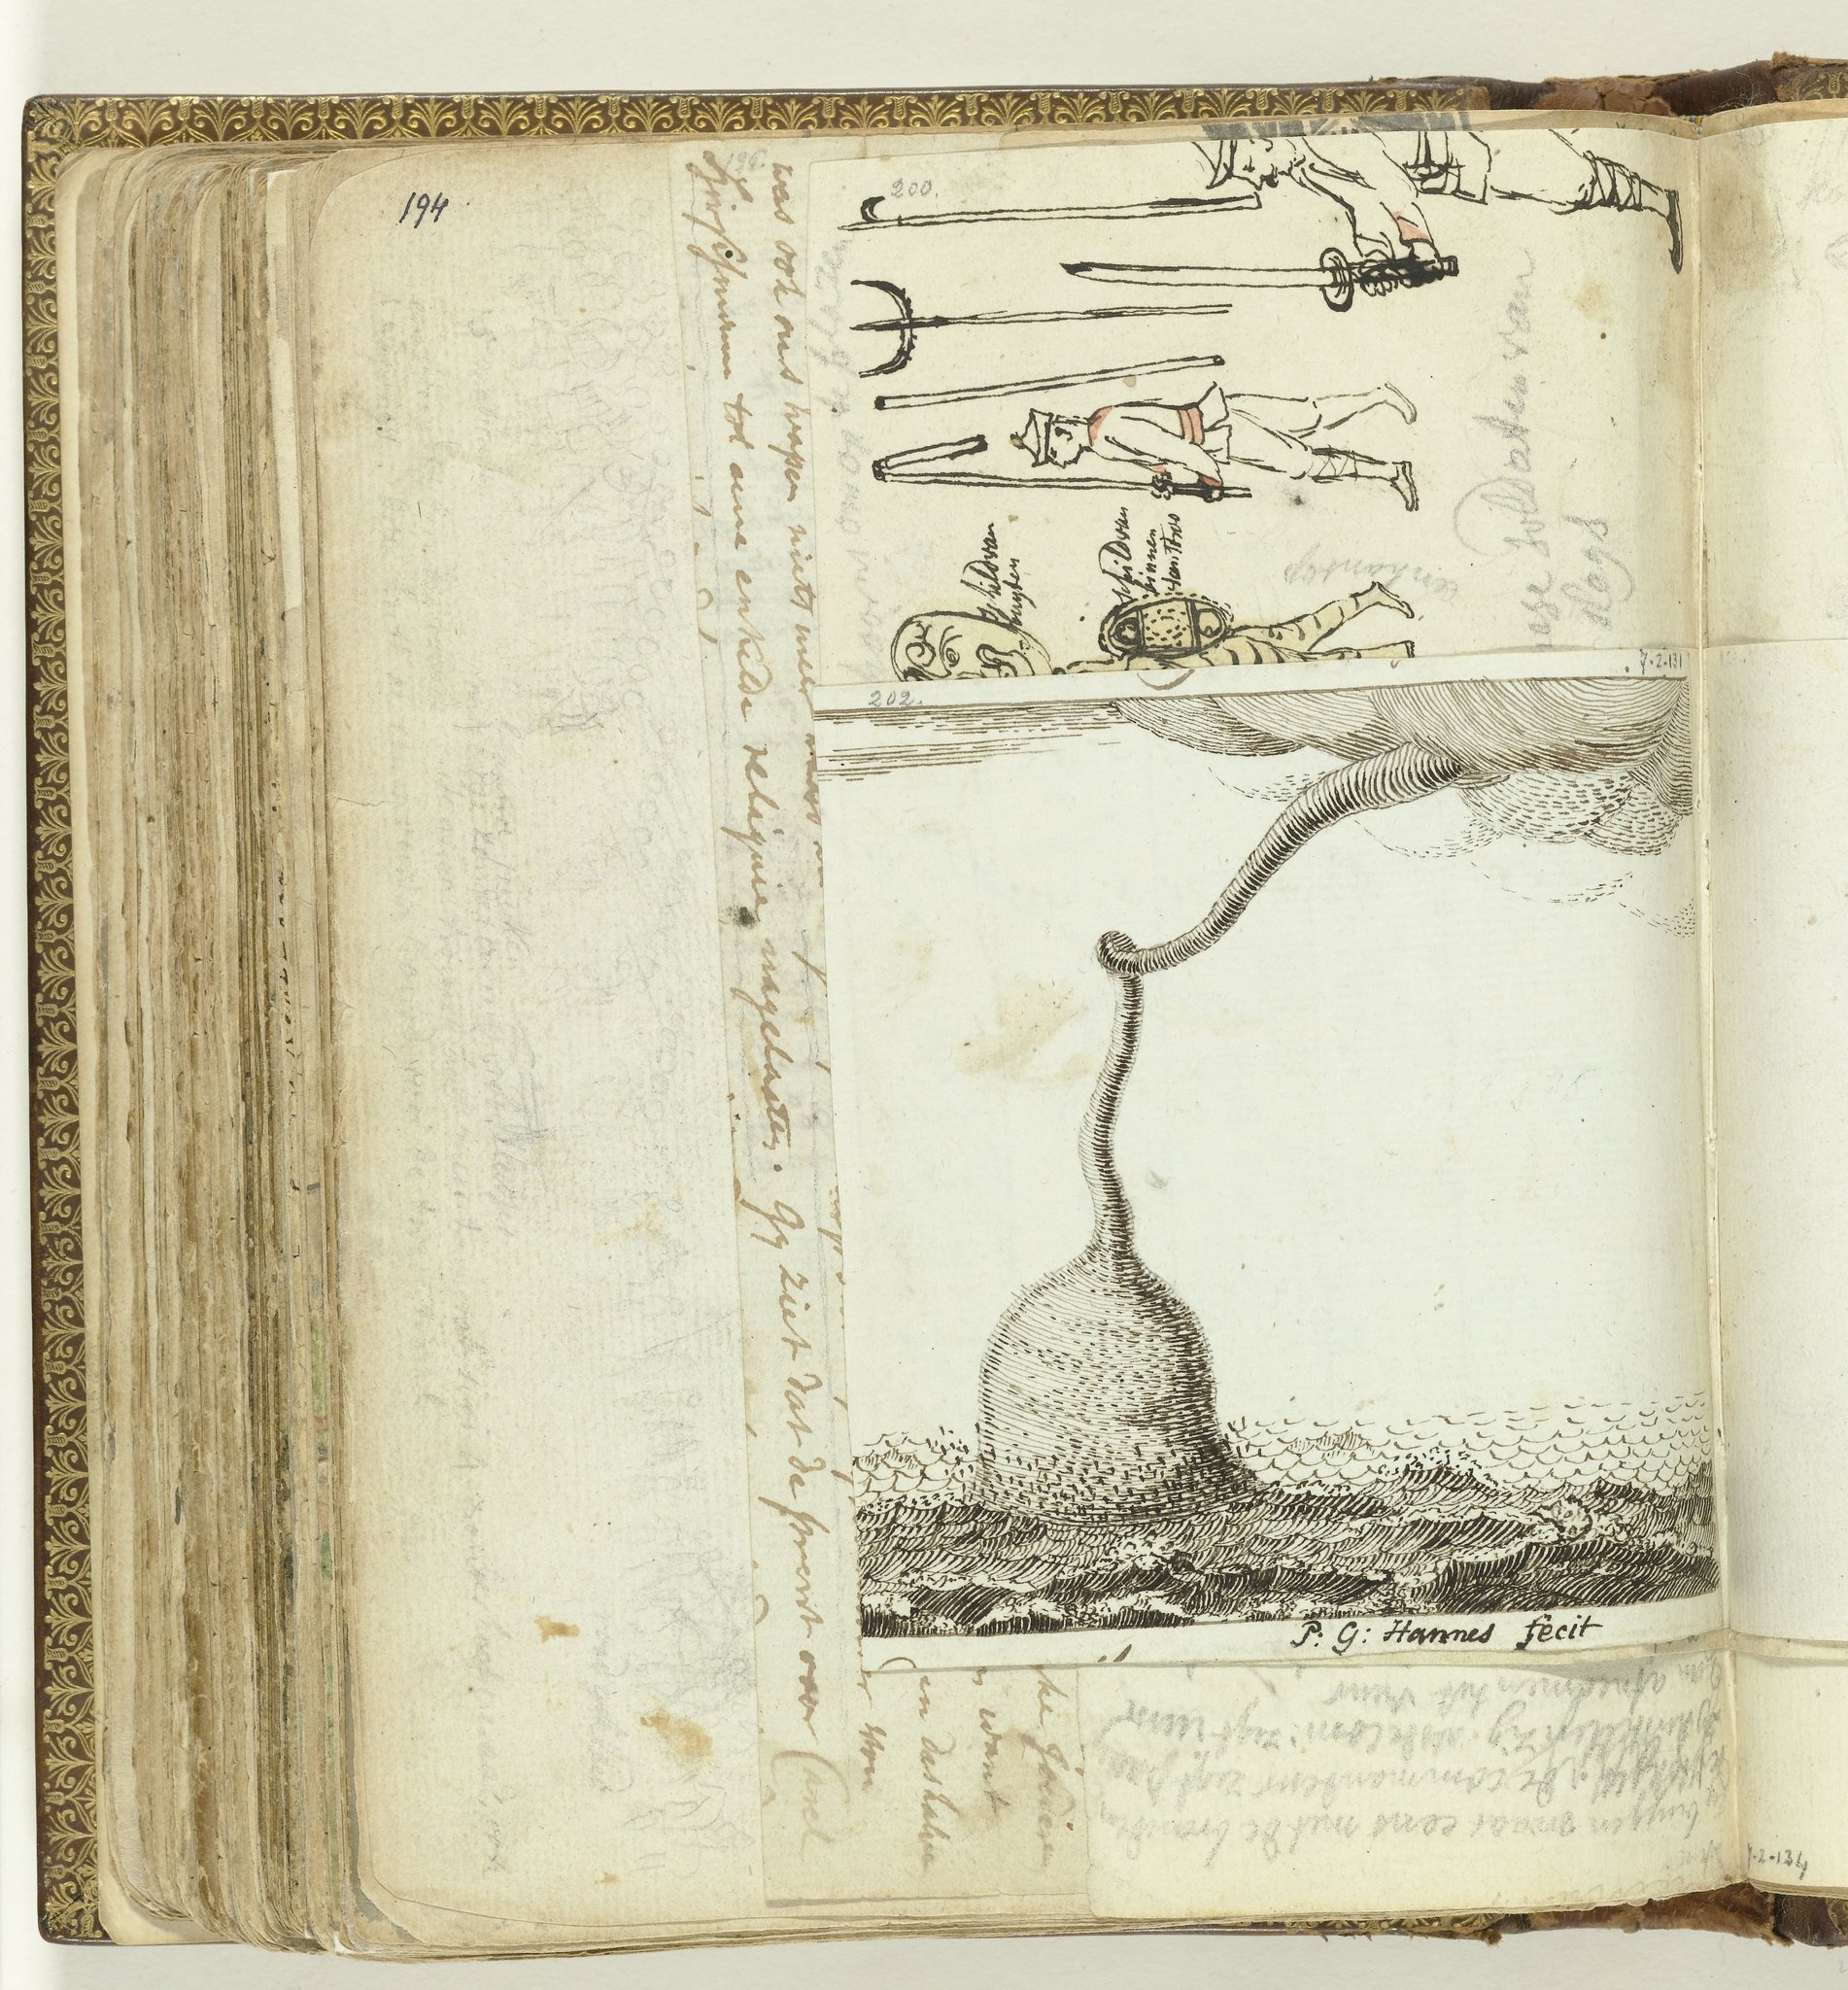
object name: drawing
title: Waterhoos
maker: jan brandes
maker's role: draughtsman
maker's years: 1743-1808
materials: ink, paper, pencil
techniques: pen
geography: atlantic ocean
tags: whirlwind, cyclone, hurricane, typhoon, tornado at sea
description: Pentekening van een windhoos op zee met opschrift 'P.G. Hannes fecit'. Denkelijk heeft Brandes van deze Hannes de tekening gecopieerd. Onderdeel uit het schetsboek van Jan Brandes, dl. 2 (1808), p. 202.